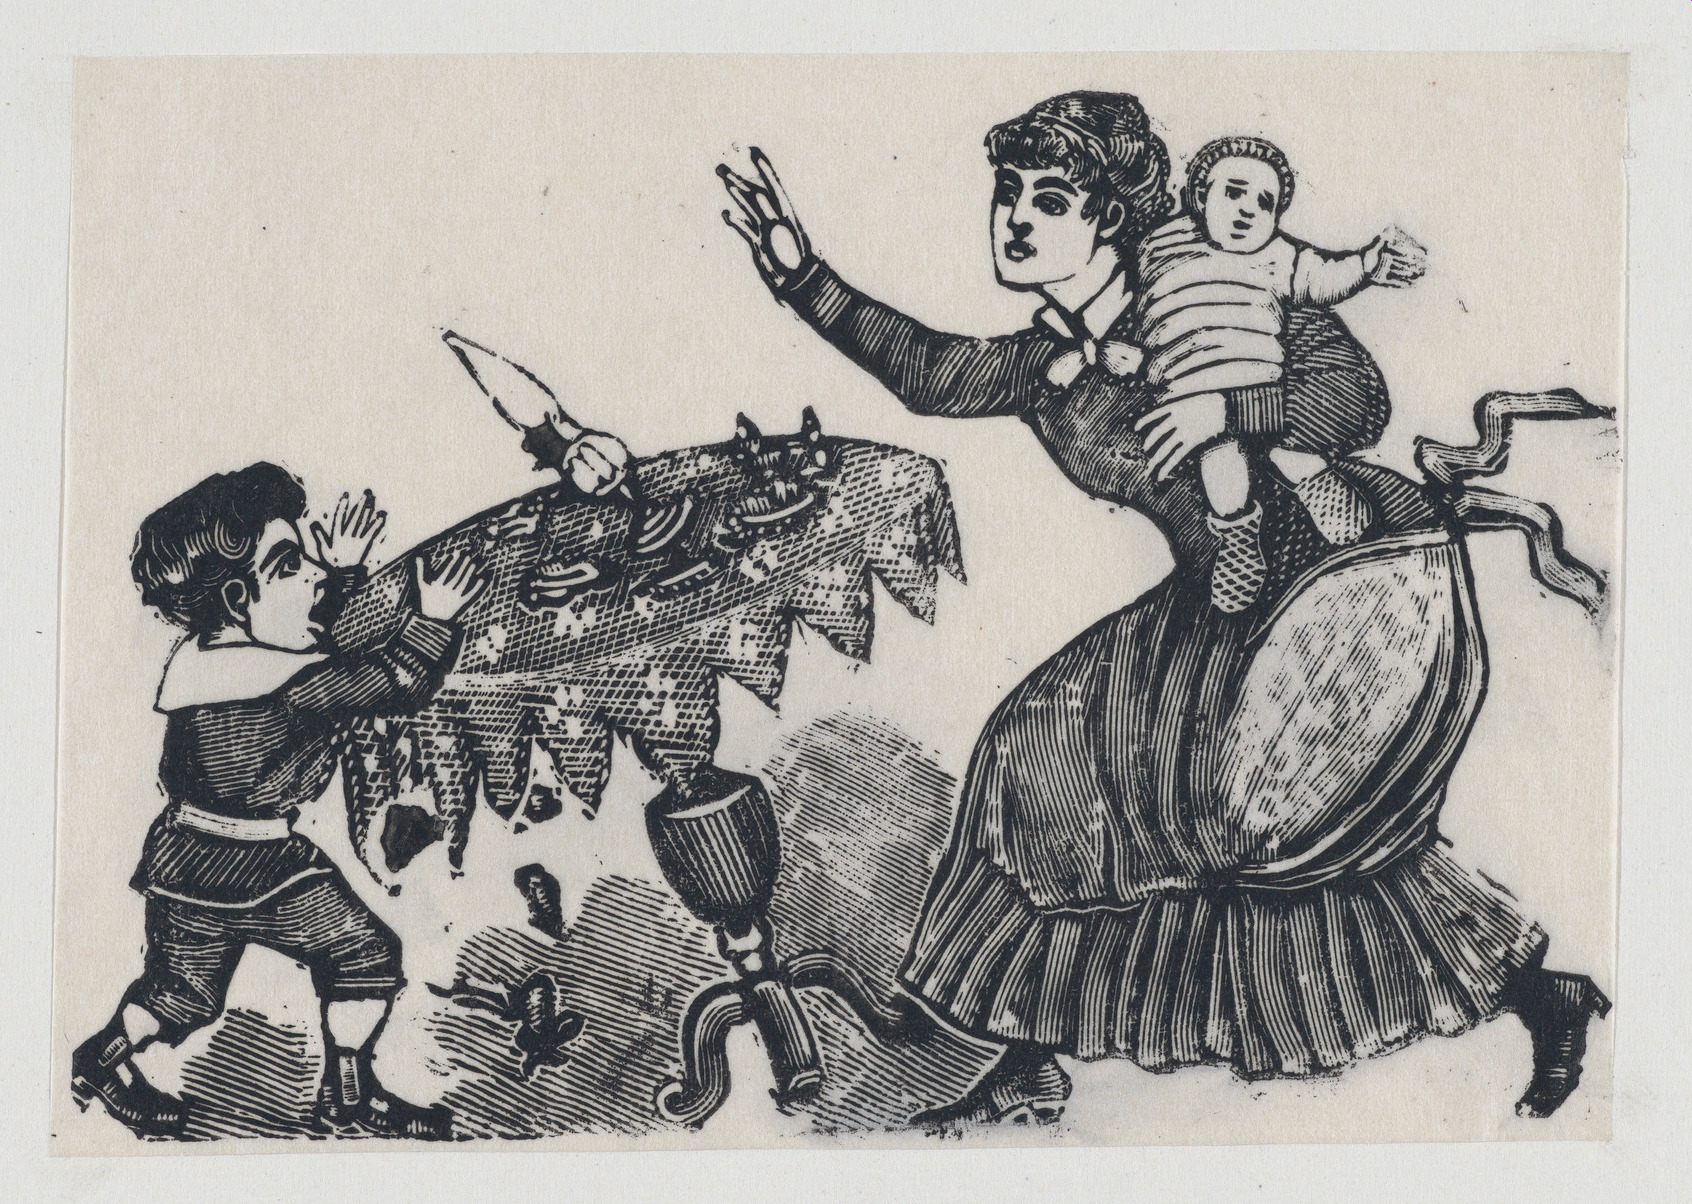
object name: print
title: A child tipping over a table, his mother rushing to stop him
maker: josé guadalupe posada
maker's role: artist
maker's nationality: mexican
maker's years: 1852-1913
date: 1890-1910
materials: metal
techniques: engraving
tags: boys,infants,mothers,tables